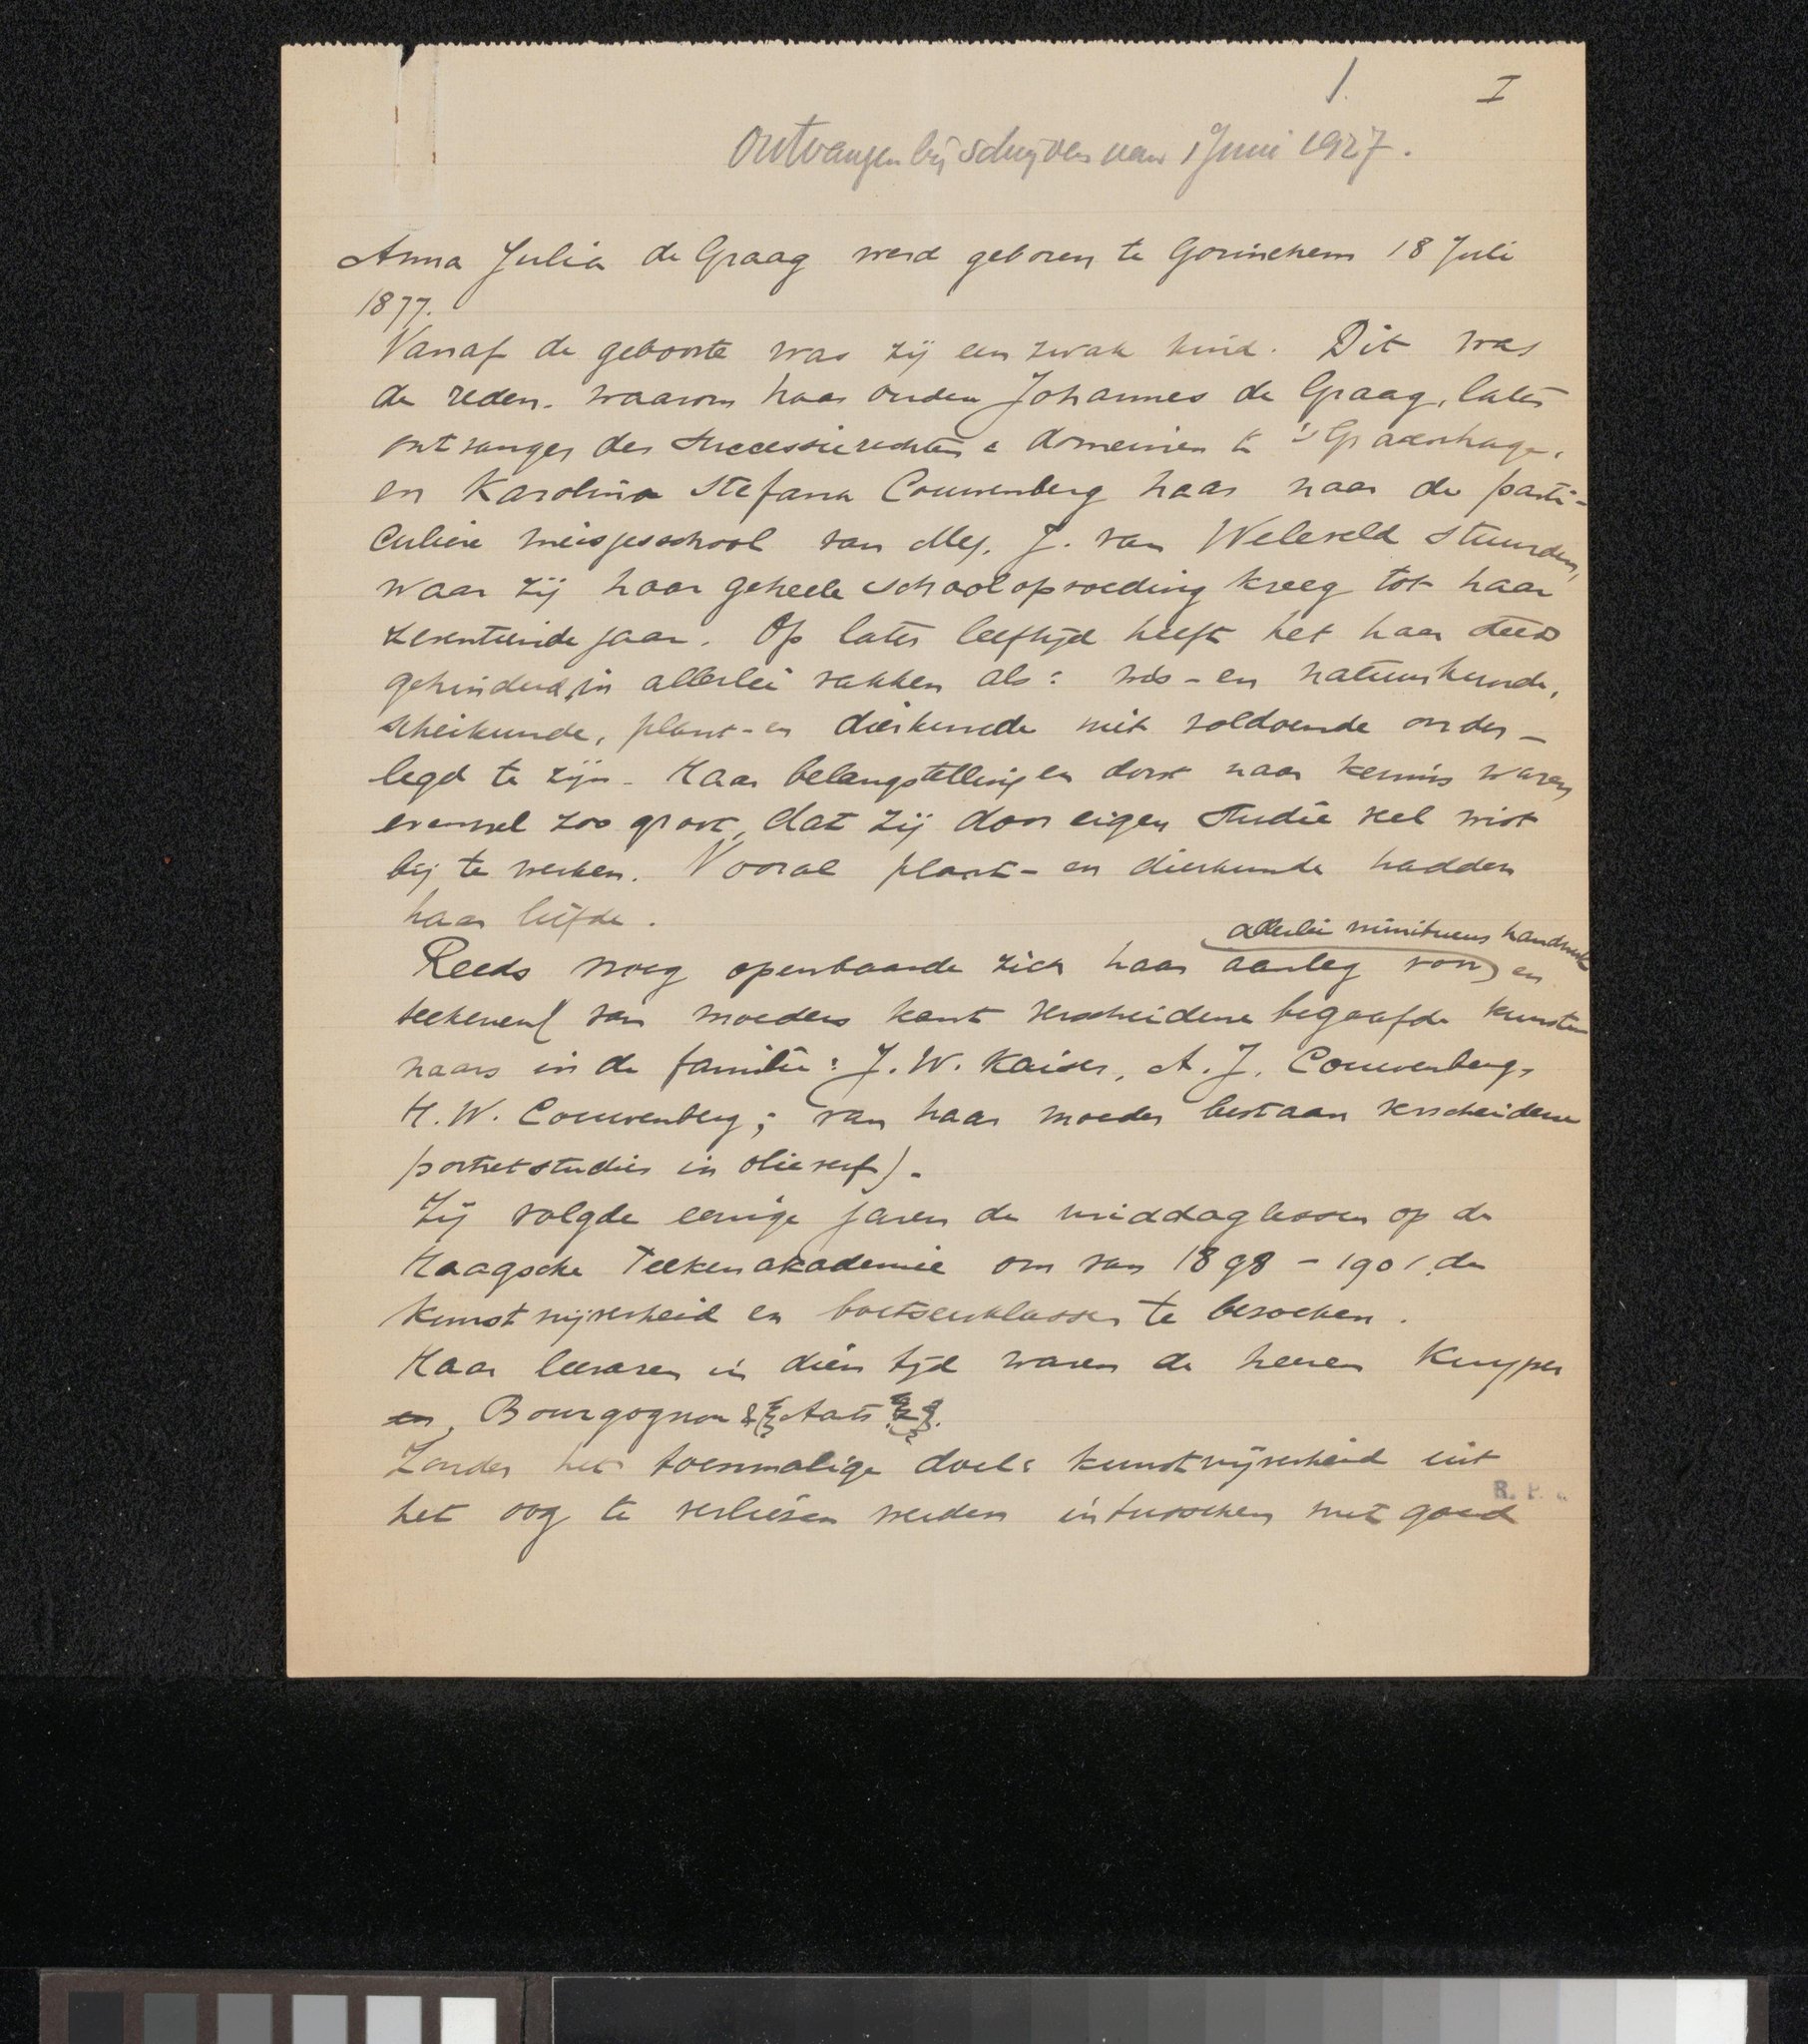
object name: manuscript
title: Handschrift betreffende Julie de Graag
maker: maria johanna de graag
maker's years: 1879-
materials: ink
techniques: pen, writing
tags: schools, johannes josephus aarts, leiden, the hague, hendricus petrus bremmer, draughtsman, julie de graag, tjitske geertruida maria van hettinga tromp, amsterdam, joseph mendes da costa (1863-1939), utrecht, artist's model, sitter, drawing, applied arts, arts and crafts; industrial design, the graphic arts, illustration ~ printed matter, book, painting (including book-illumination, miniature-painting)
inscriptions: collector's mark: Lugt 2233